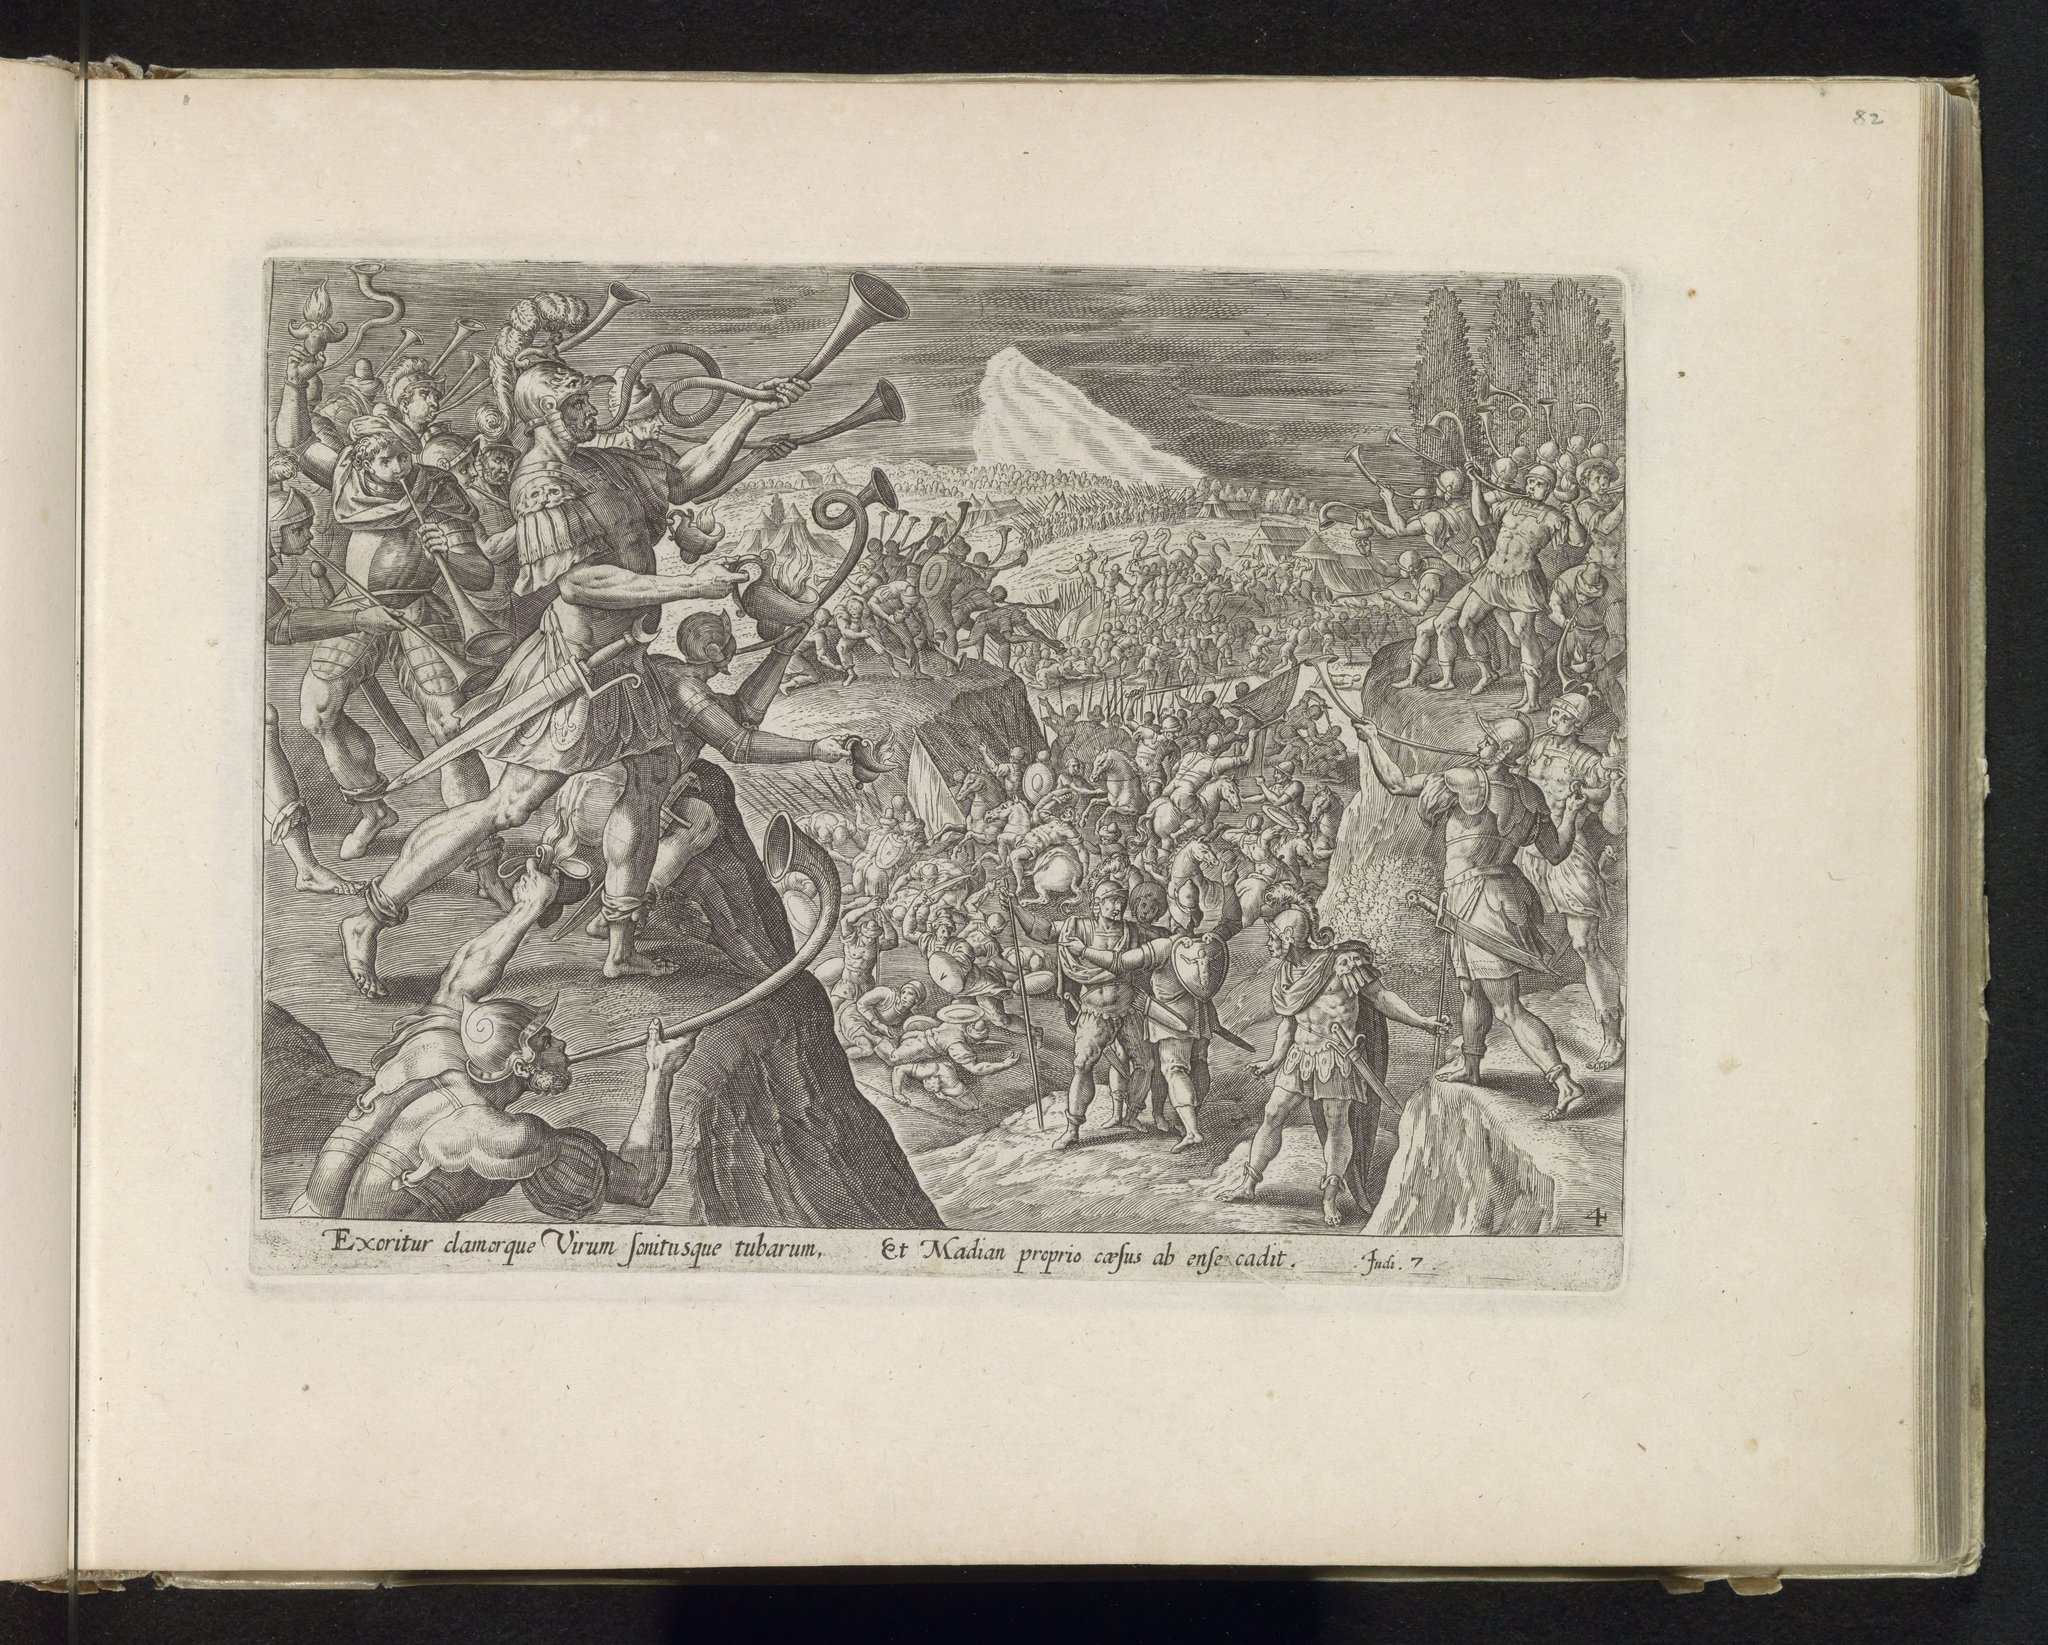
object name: print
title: Thesaurus sacrarum historiaru[m] veteris testame[n]ti, elega[n]tissimis imaginibus expressu[m] excelle[n]tissimoru[m] in hac arte viroru[m] opera: nu[n]c primu[m] in luce[m] editus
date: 1585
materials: paper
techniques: engraving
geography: antwerp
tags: the attack on the midianites: gideon and his men blow their trumpets, break their pitchers, and hold their lamps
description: Gideon en zijn mannen overvallen de Midjanieten. Rond het kamp blazen Gideons mannen op ramshoorns. In hun handen houden ze waterkruiken met fakkels erin. De Midjanieten denken dat ze worden aangevallen, trekken het zwaard en beginnen hun eigen mannen te bevechten. Onder de voorstelling een verwijzing in het Latijn naar de Bijbeltekst in Ri. 7. Deze prent maakt deel uit van een album.